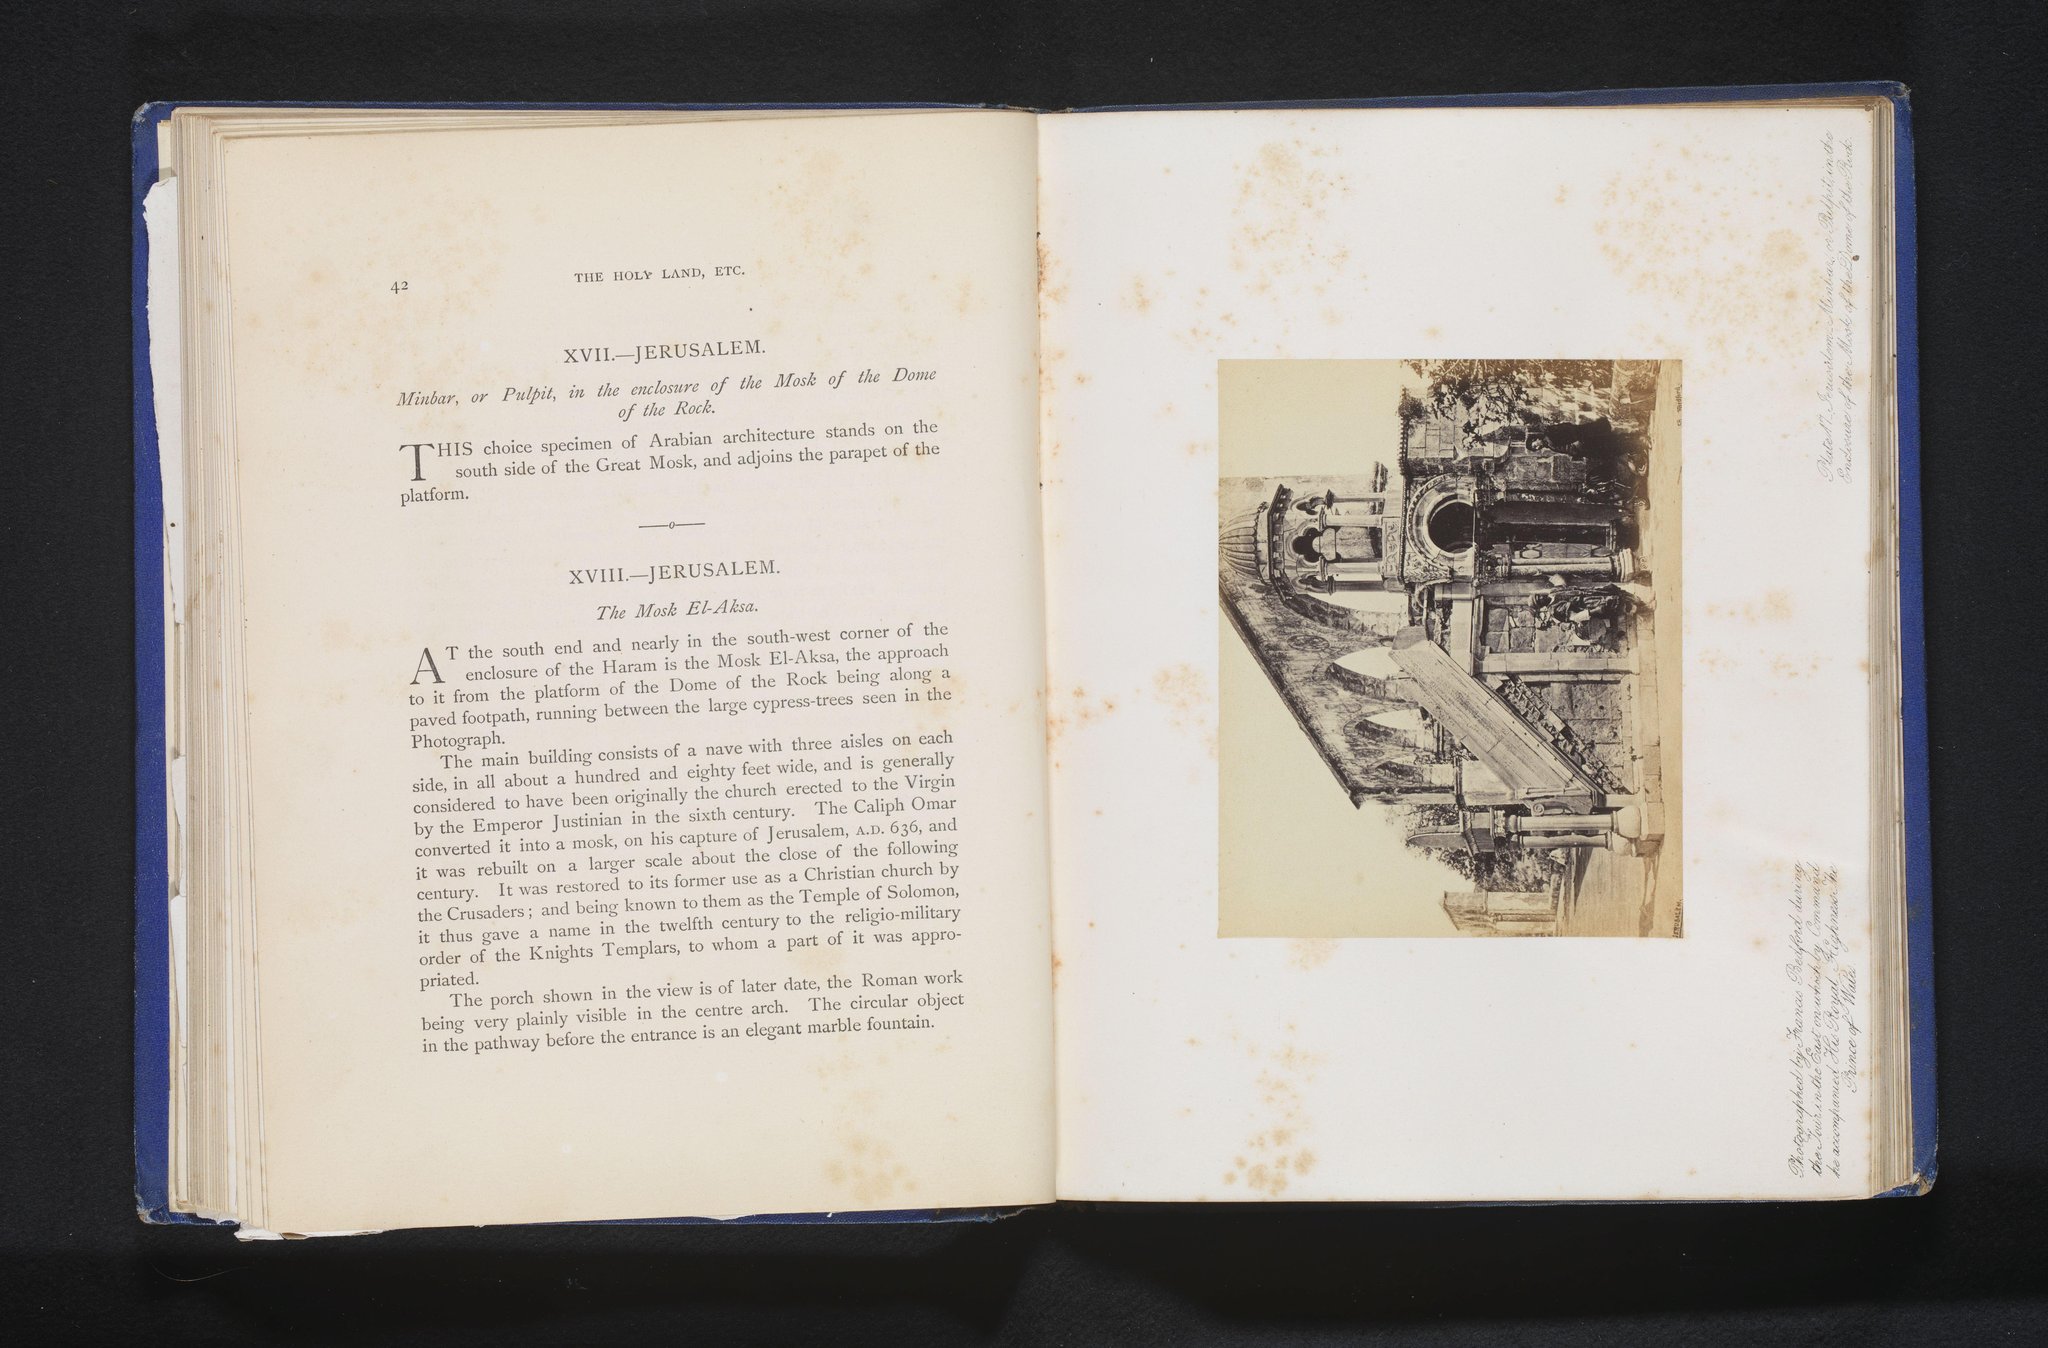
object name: photograph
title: Jerusalem-Minbar or Pulpit, in the enclosure of the Mosk of the Dome of the Rock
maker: francis bedford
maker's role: print maker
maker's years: 1815-1894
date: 1861-1866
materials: photographic support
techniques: albumen print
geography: jerusalem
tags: pulpit, ambo, chancel, temple, shrine ~ islam, mohammedanism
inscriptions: inscription: ‘Photographed by Francis Bedford during the Tour in the East on which by Command he accompanied His Royal Highness The Prince of Wales’, number: ‘Plate 17.’